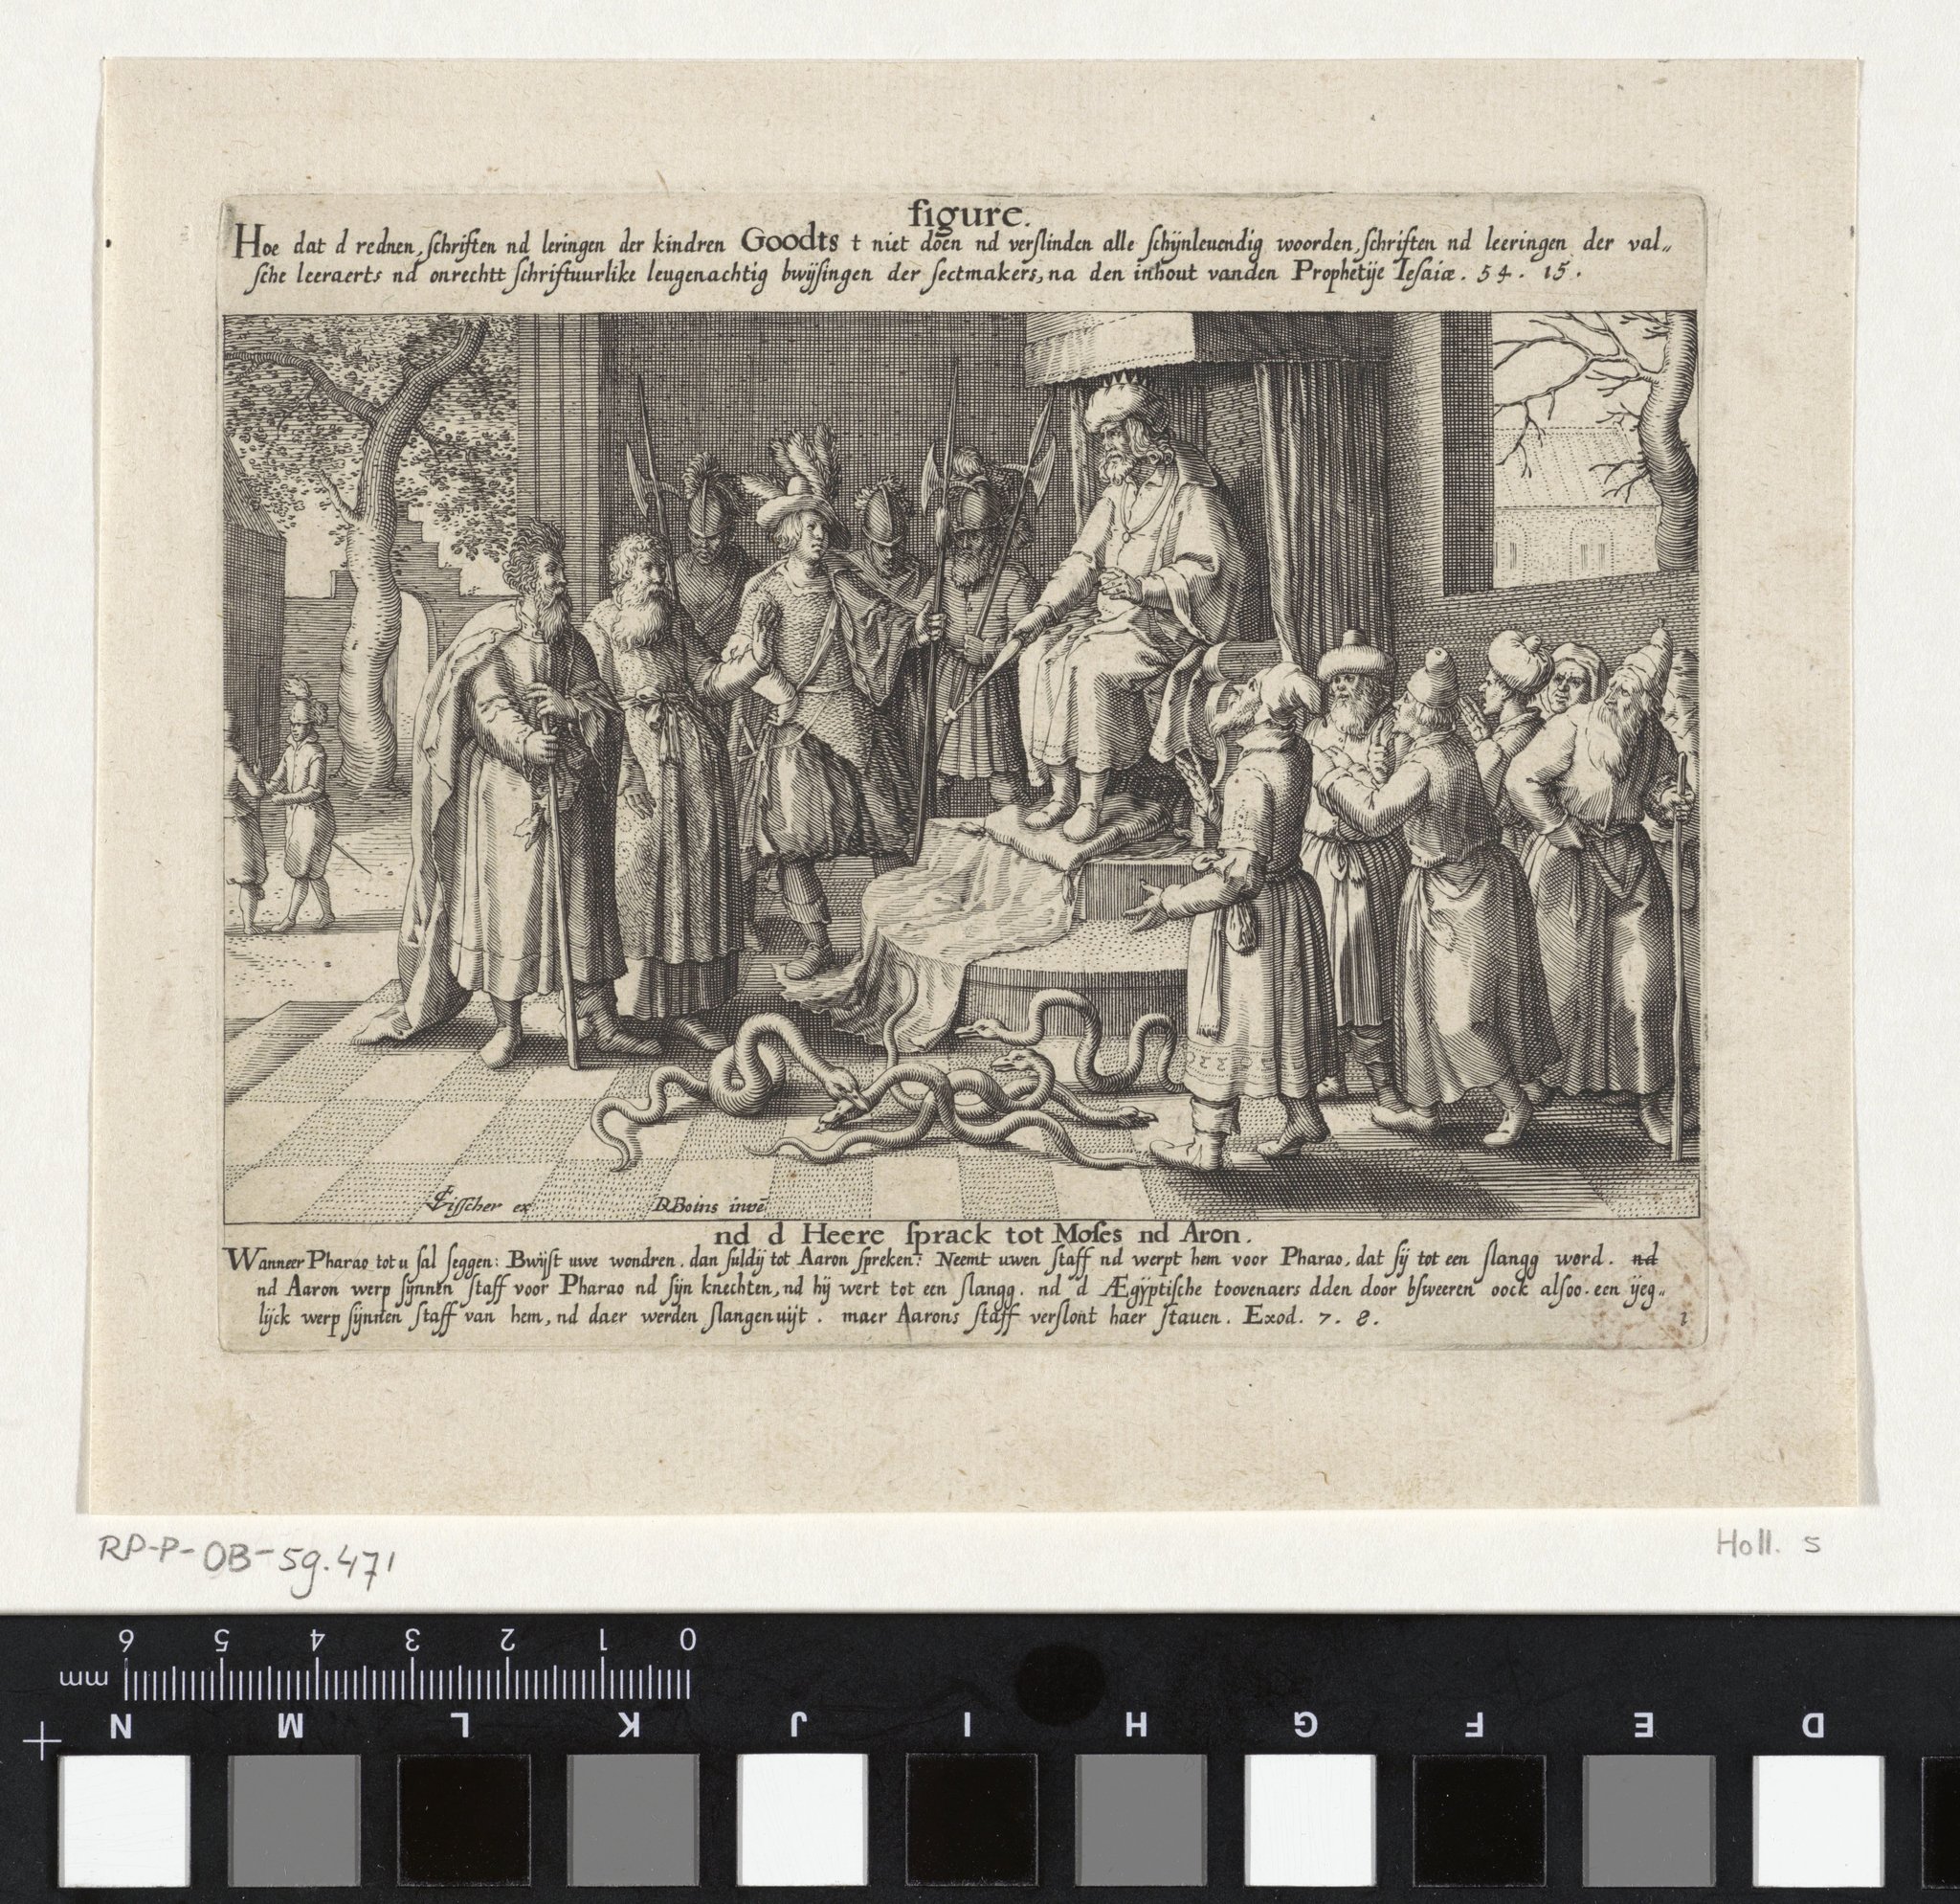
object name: print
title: Bijbelse thema's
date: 1611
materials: paper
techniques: engraving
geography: amsterdam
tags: moses and aaron before pharaoh; aaron performs the miracle of the rod changing into a snake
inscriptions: collector's mark: Lugt 240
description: Mozes en Aäron staan voor de Farao op zijn troon. Op de grond kronkelen de slangen die uit de staf van Aäron en de aanwezige Egyptische tovenaars ontstonden. Boven en onder de afbeelding verwijzingen naar de Bijbelteksten Jesa. 54:15 en Ex. 7:8. Rechtsonder genummerd "1".